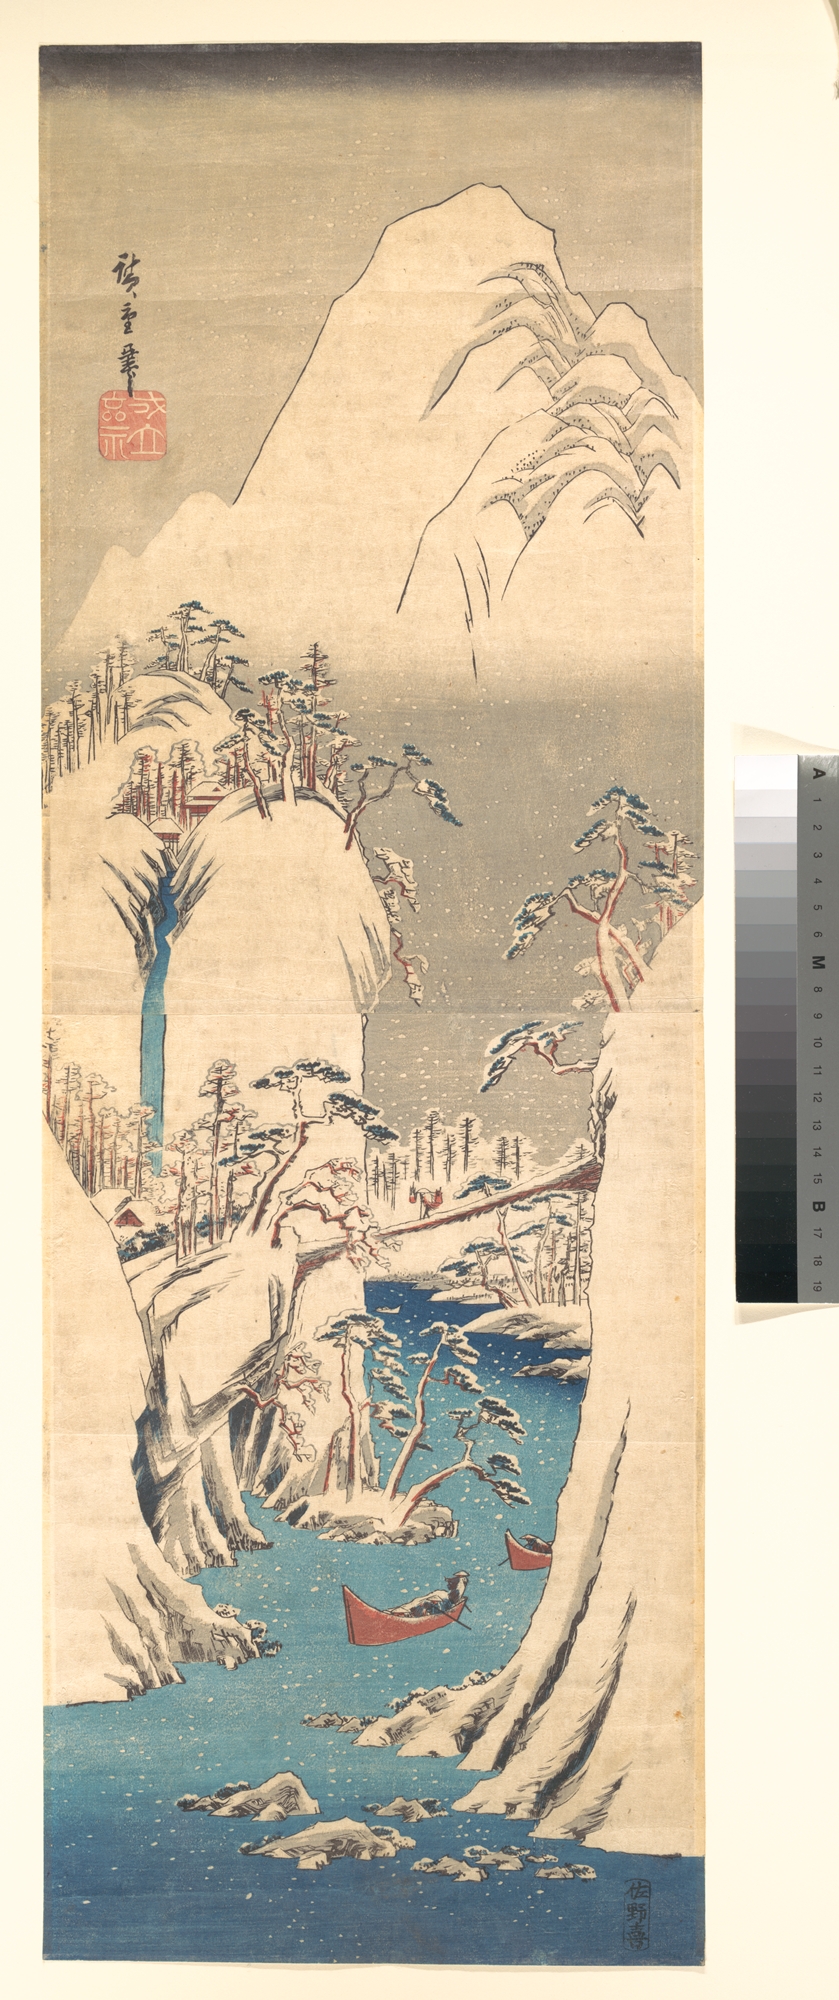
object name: print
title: River Gorge in Snow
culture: japanese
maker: utagawa hiroshige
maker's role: artist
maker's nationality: japanese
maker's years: 1797-1858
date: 1797-1858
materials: ink, paper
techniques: woodblock print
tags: rivers,mountains,trees,snow,boats